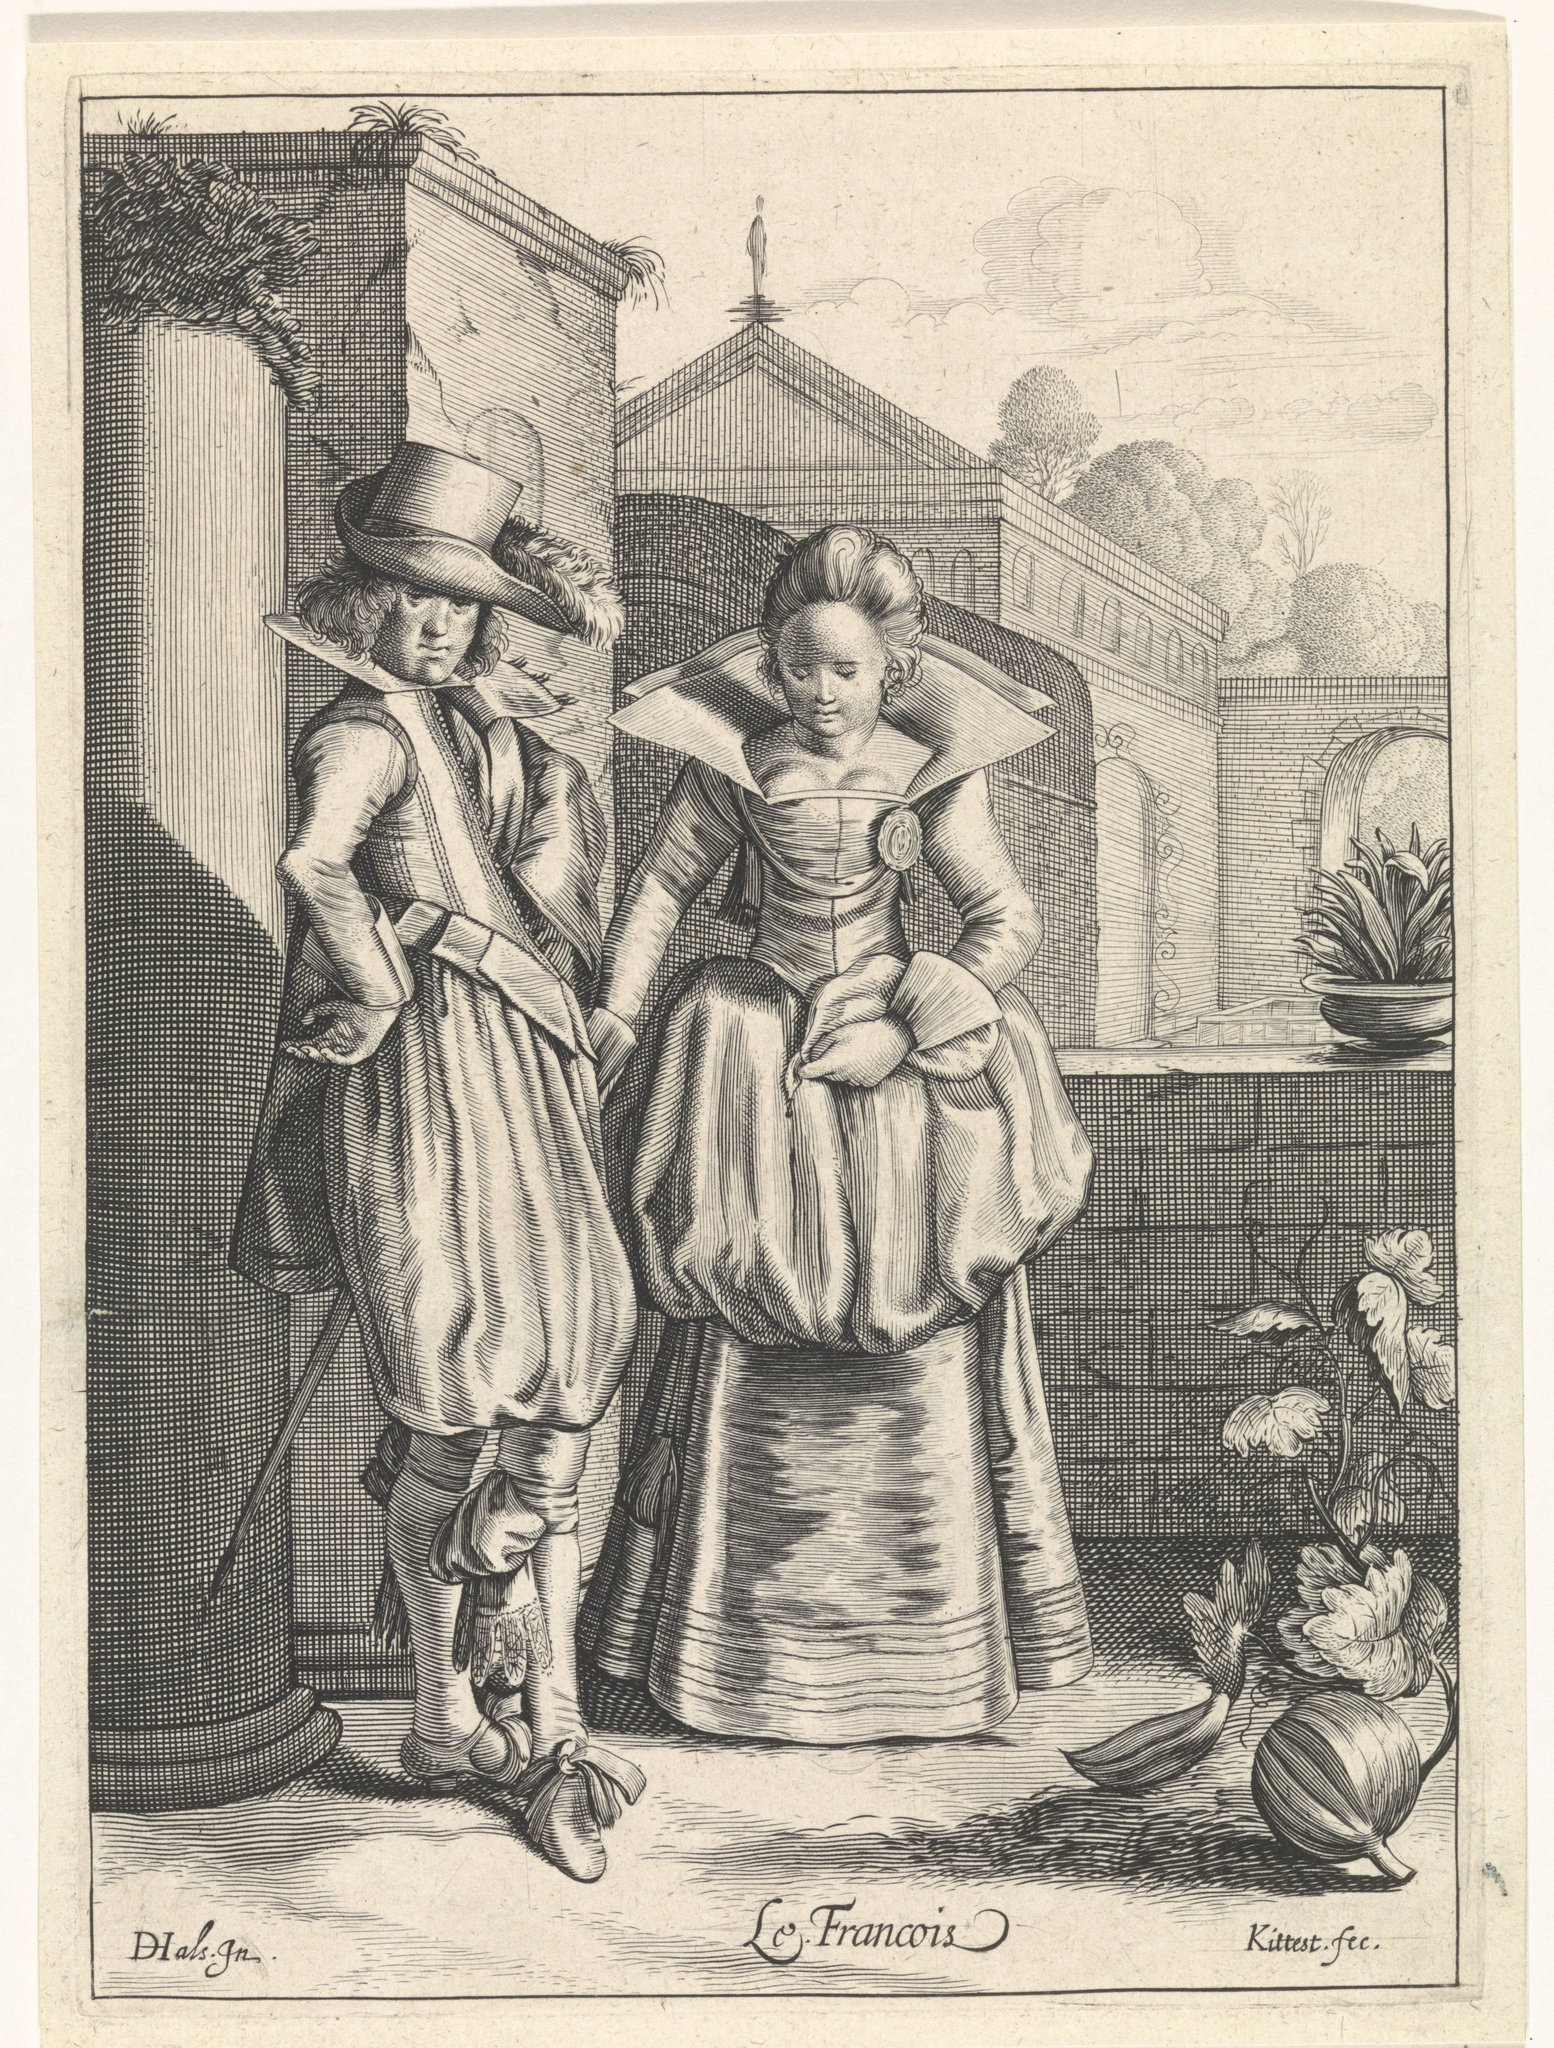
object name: print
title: Kostuums in Europa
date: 1610-1638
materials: paper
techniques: engraving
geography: netherlands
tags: europeans (with name) (+ costume), clothes, costume (+ women's clothes), handkerchief, clothes, costume (+ men's clothes), plants and herbs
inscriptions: collector's mark: Lugt 240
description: Kleding man: hoed met brede opgeslagen rand en veer; wambuis met puntvormige schootpanden, kleine schouderrol; pofbroek tot op de knie met gestrikte kniebanden. Schoenen met striksluiting. Kleding vrouw: dubbele hoog opstaande kraag, sluitend aan vierkante halsuitsnijding waarop links een rozet. Kleine oorbel. Opgeschorte overrok. Zakdoek in de hand.